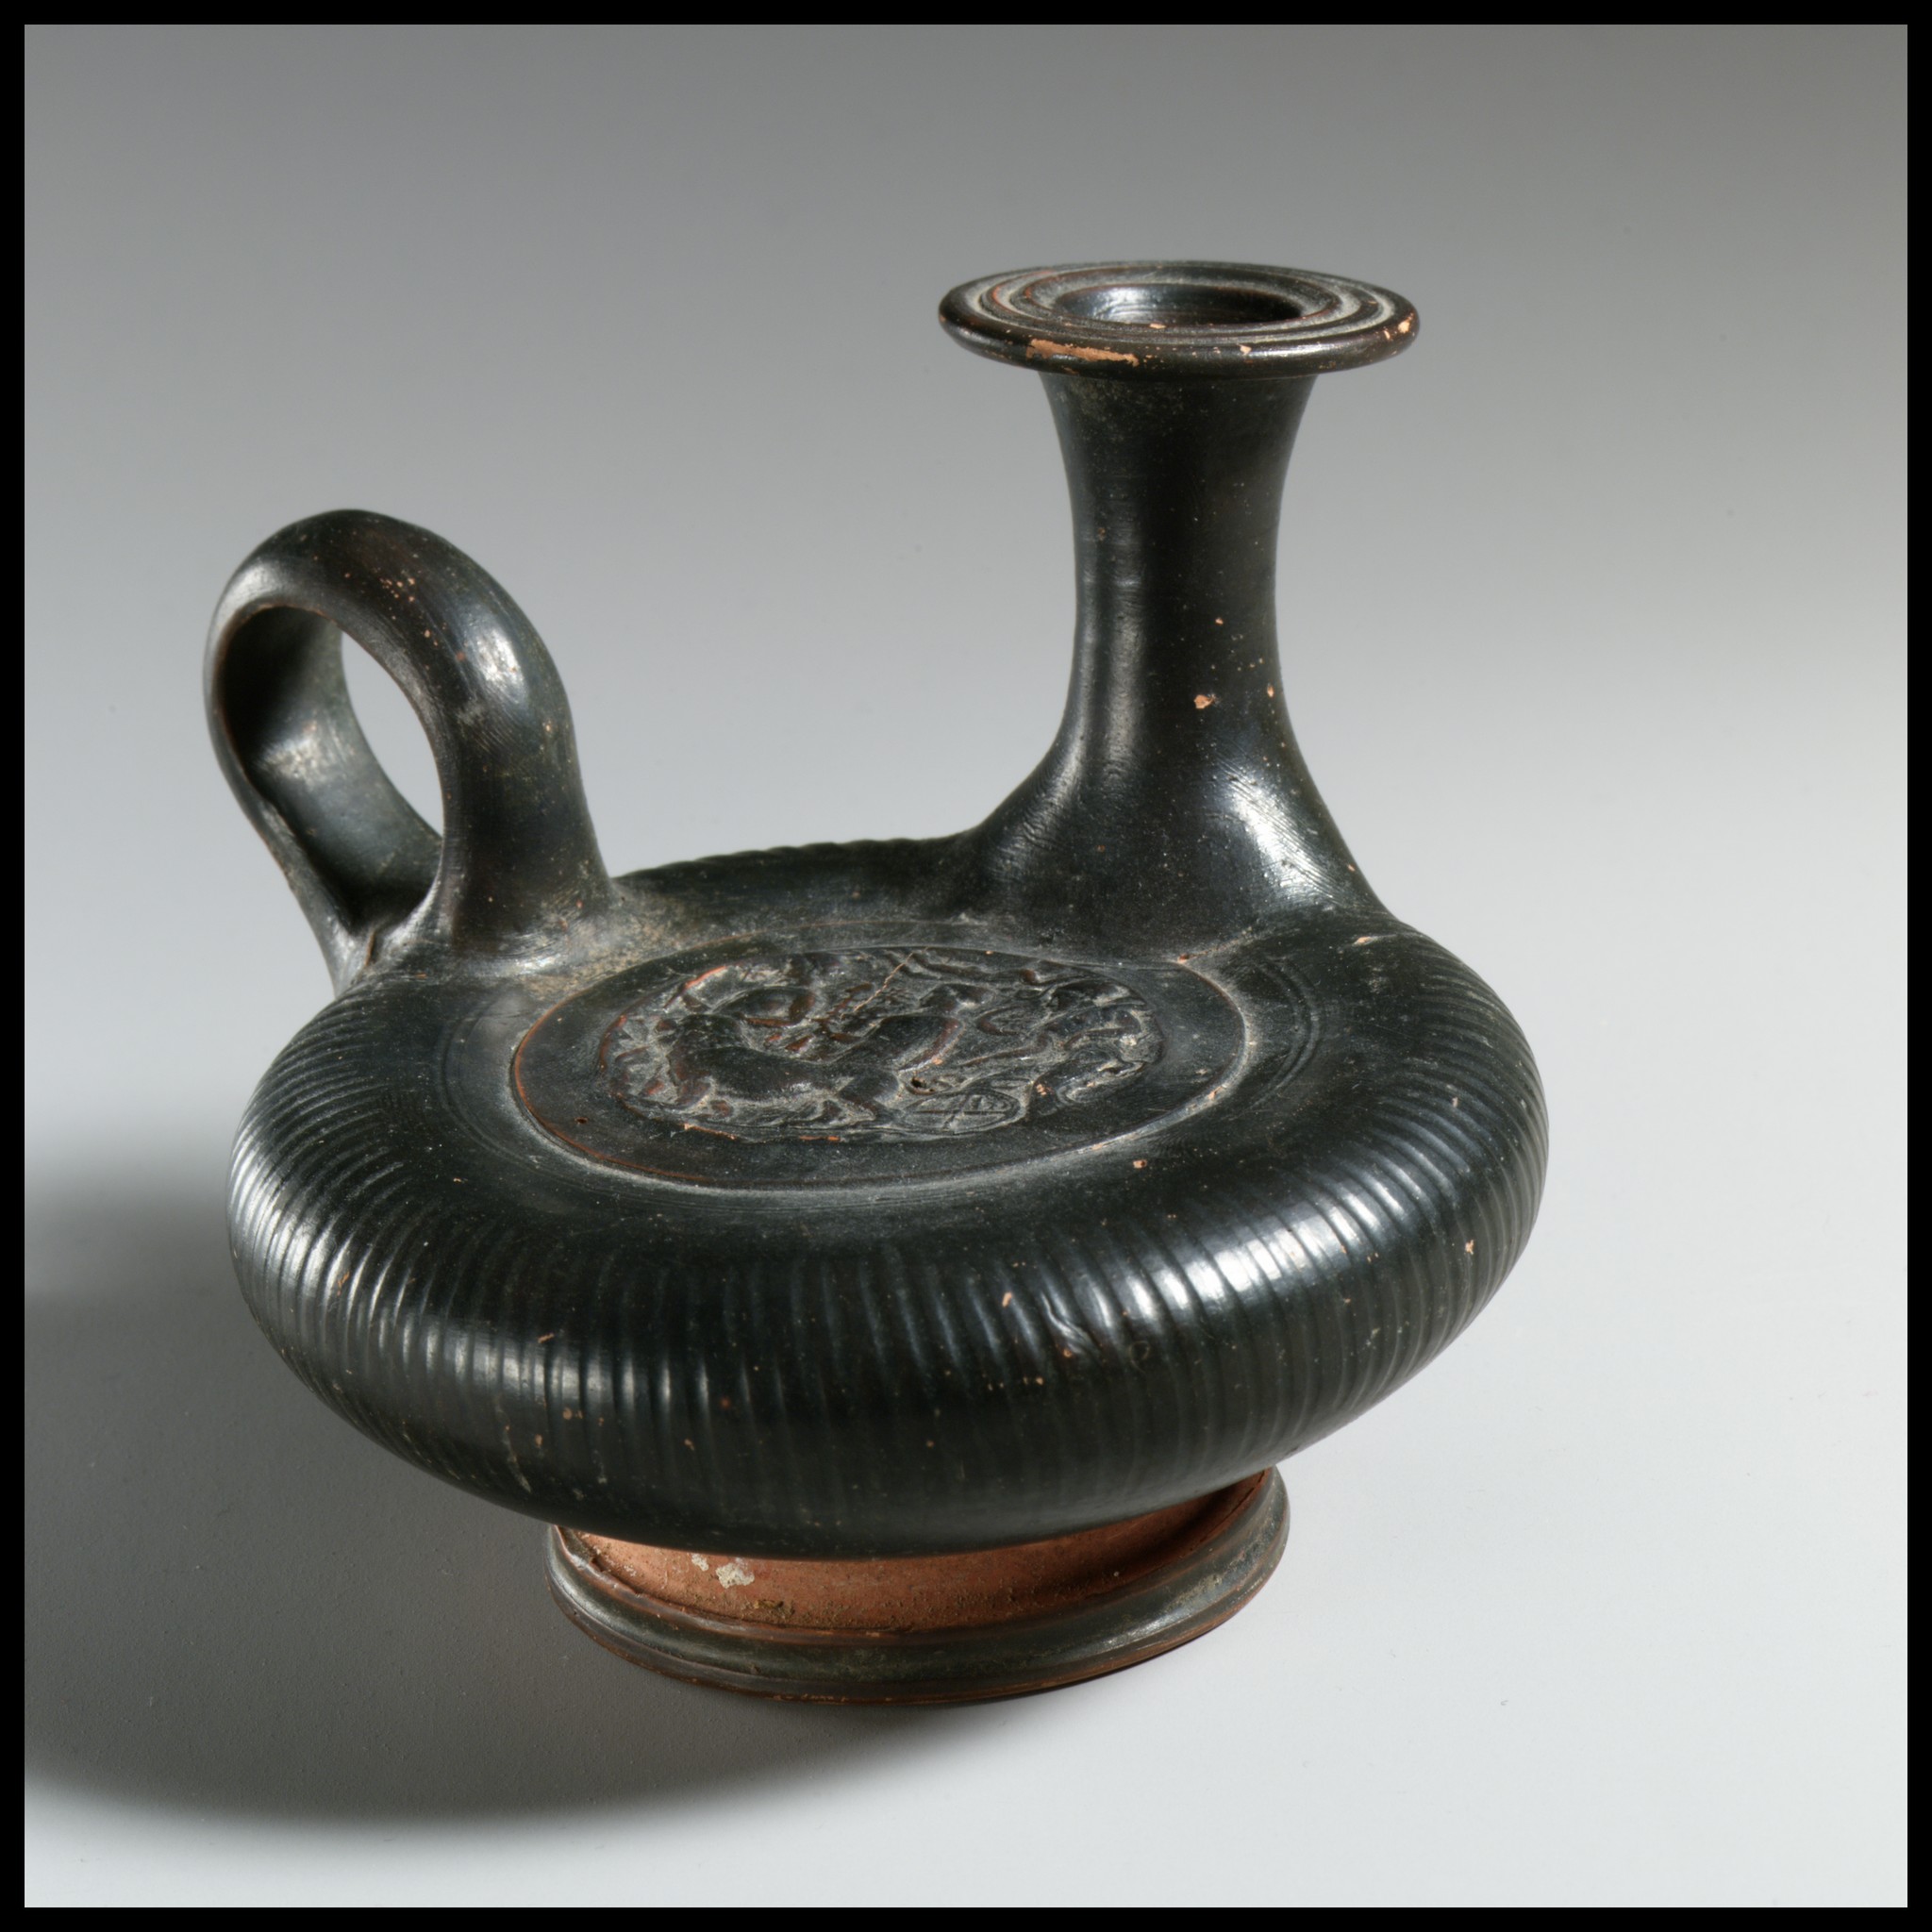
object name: guttus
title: Terracotta guttus (flask with handle and vertical spout)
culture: greek or south italian or campanian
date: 400-201 BCE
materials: terracotta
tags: lions,cybele